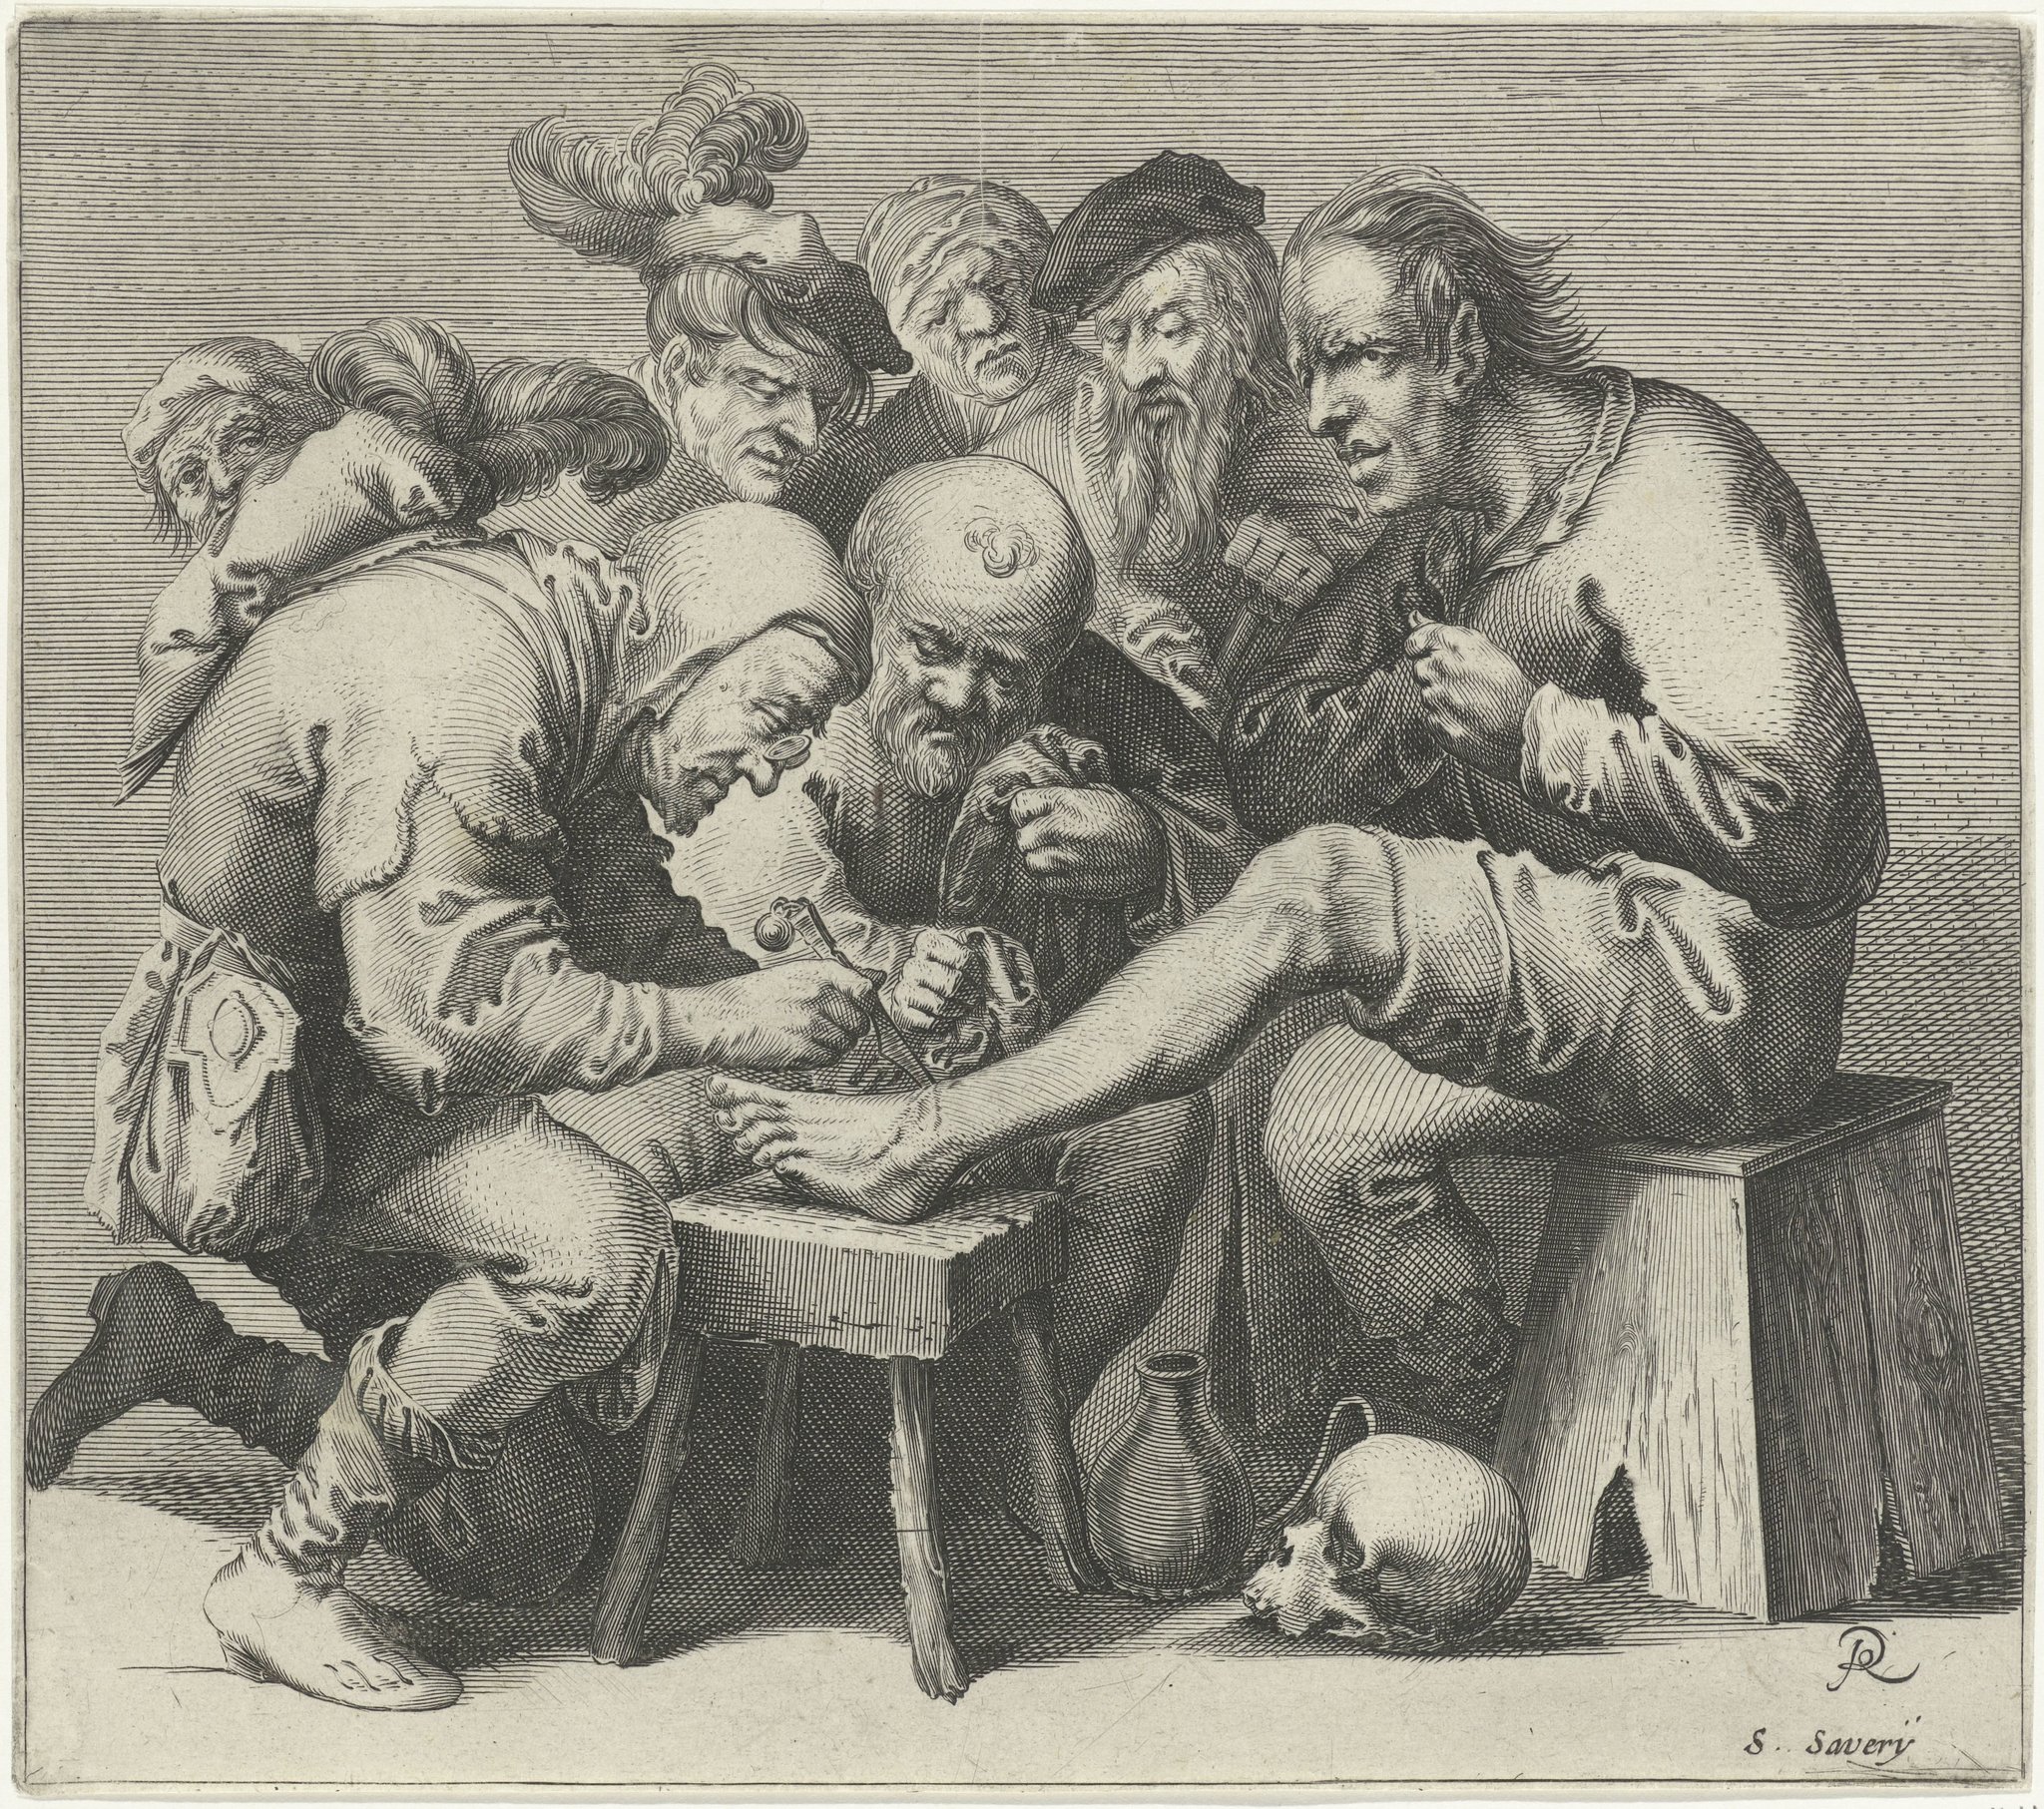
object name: print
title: Voetoperatie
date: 1630-1645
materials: paper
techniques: engraving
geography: netherlands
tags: eyeglasses, spectacles, (human) skull, farmers, operation, surgery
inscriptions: collector's mark: Lugt 240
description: Een chirurg voert, in het bijzijn van vijf personen, een operatie uit aan de voet van een man.